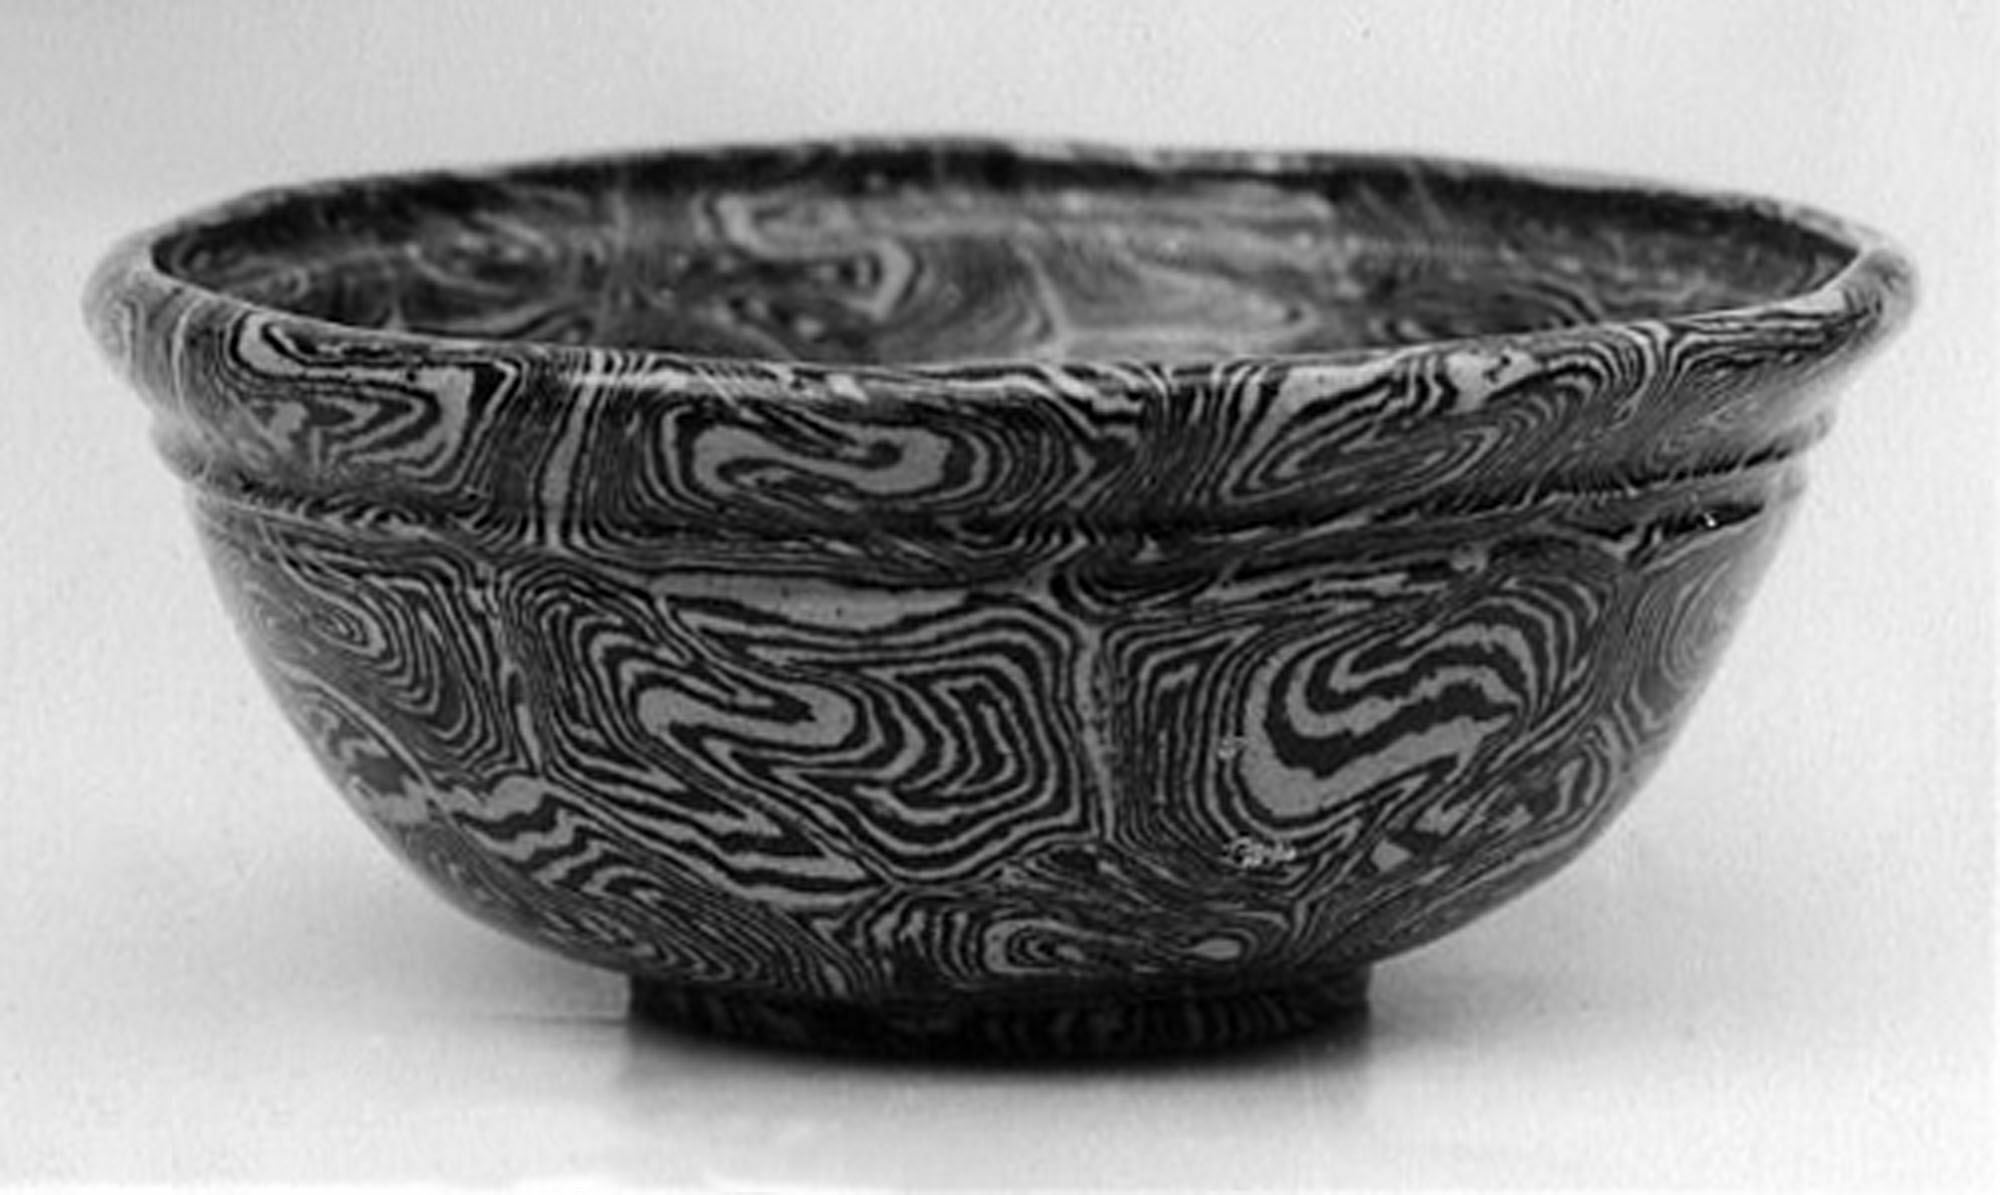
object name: bowl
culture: chinese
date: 1736-1795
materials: porcelain